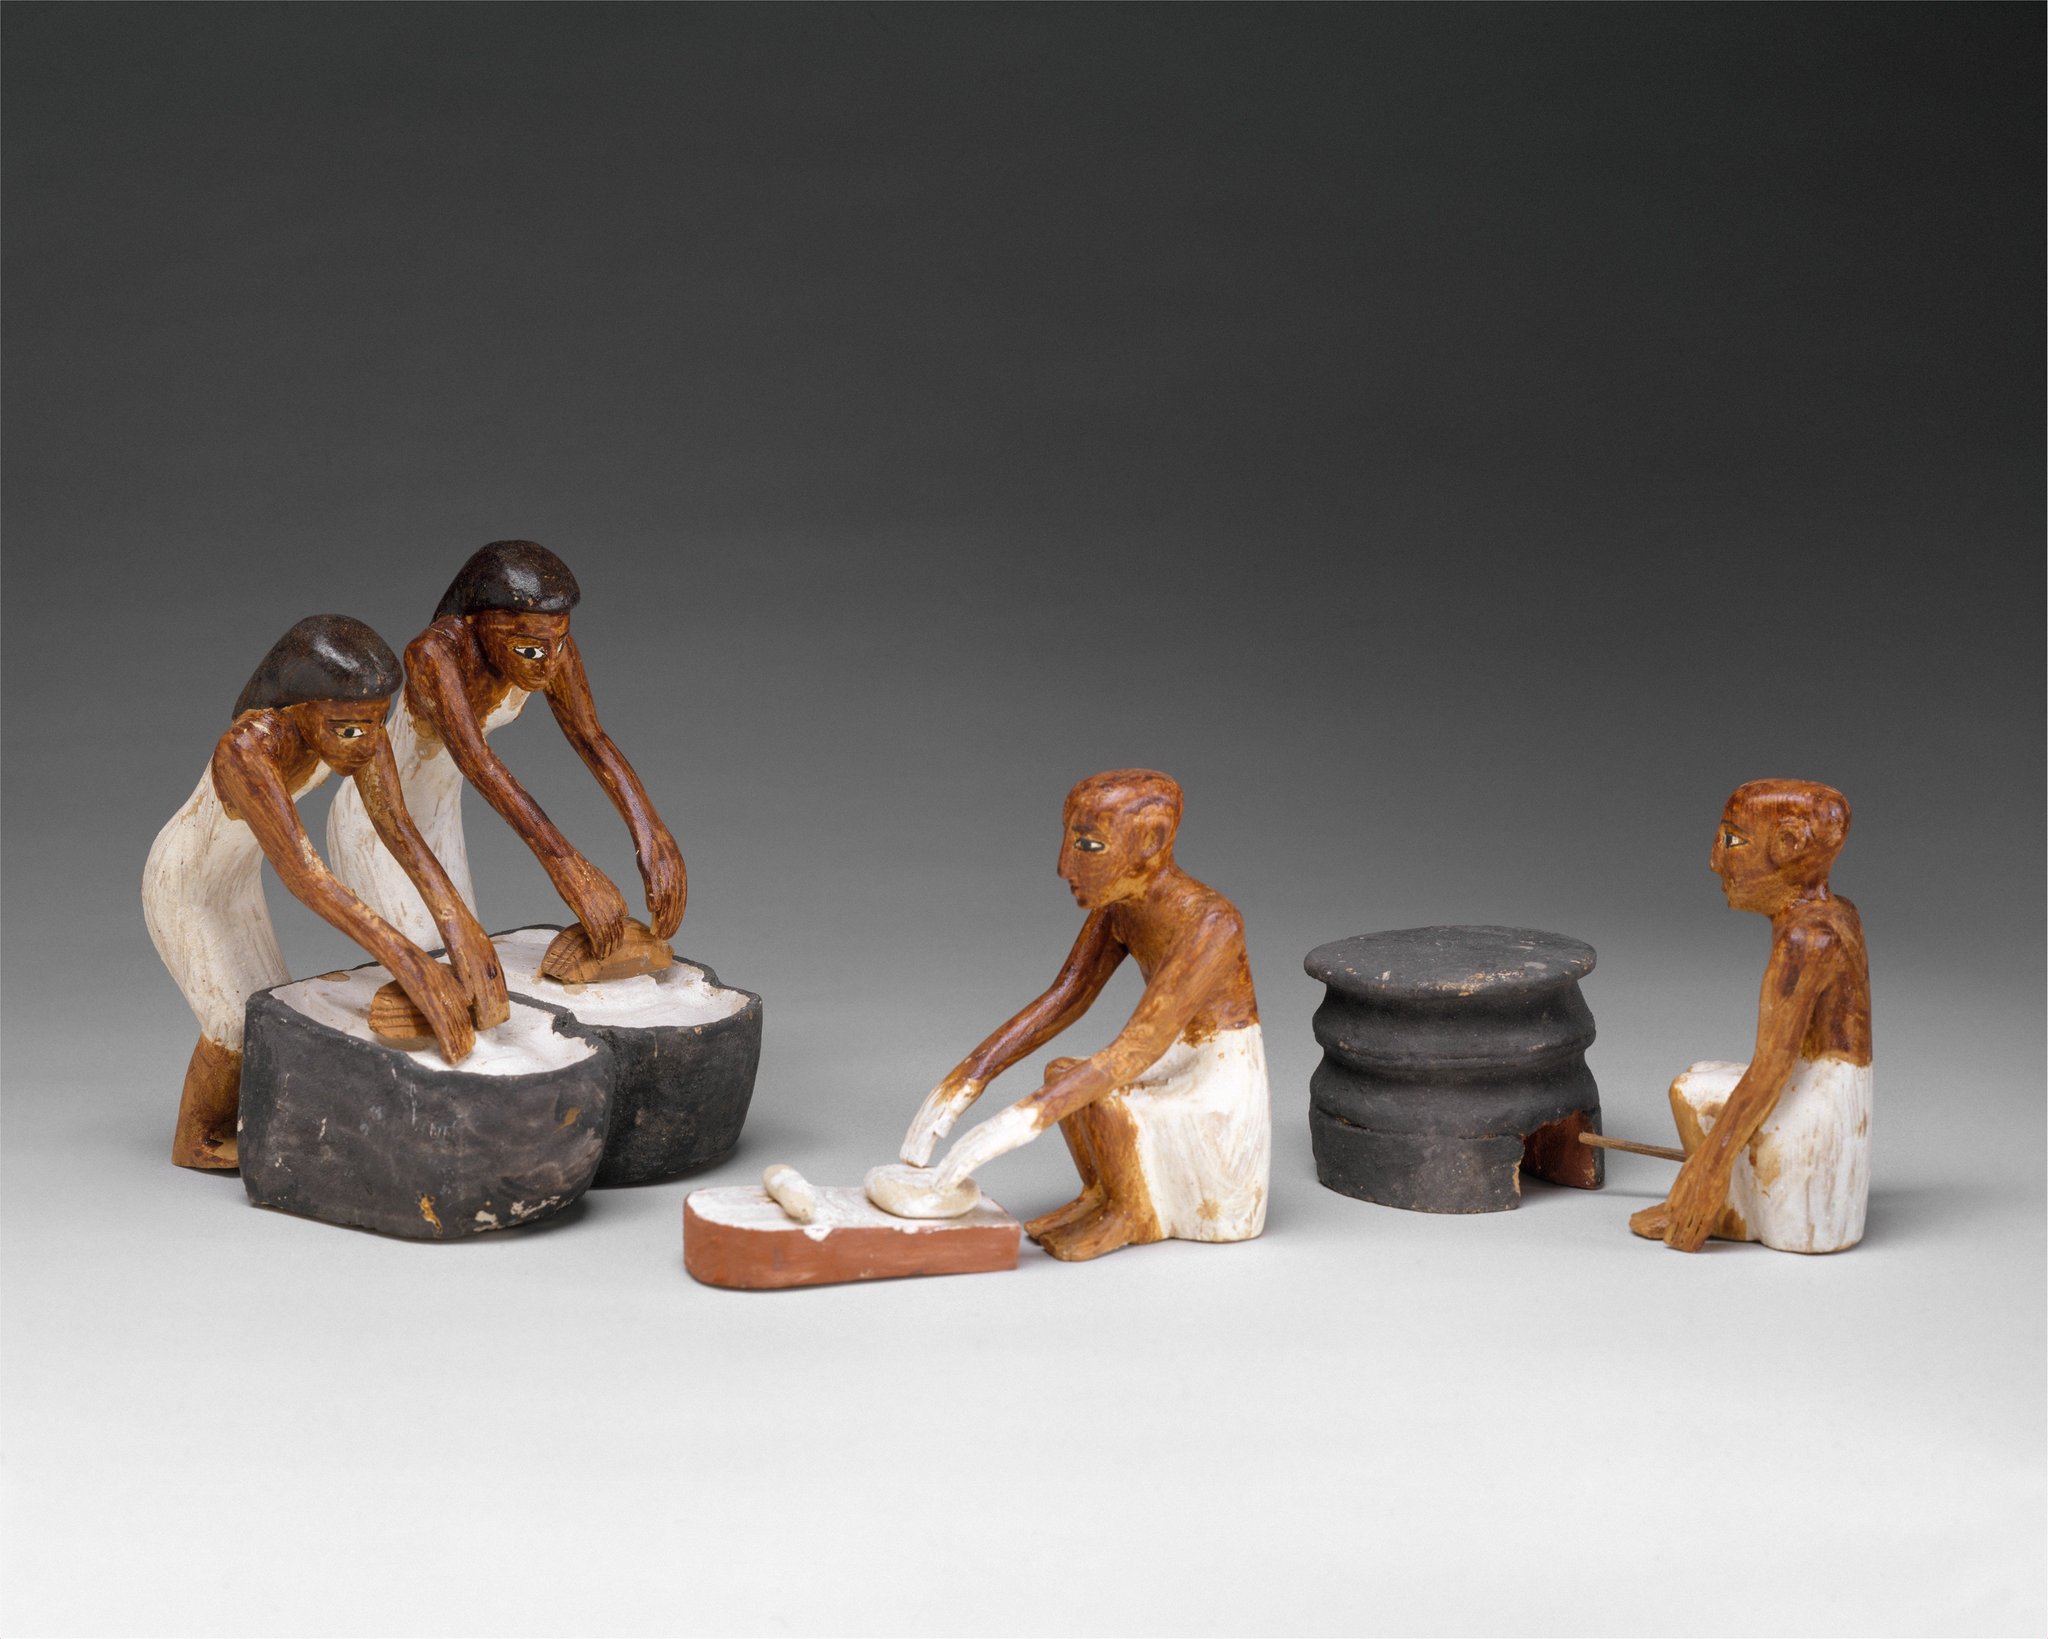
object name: model, bakery, brewery, meketre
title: Bakers and Brewers from Meketre's Model Bakery and Brewery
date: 1981-1975 BCE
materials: gesso, linen, paint, wood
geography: egypt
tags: men,women,working,bakers